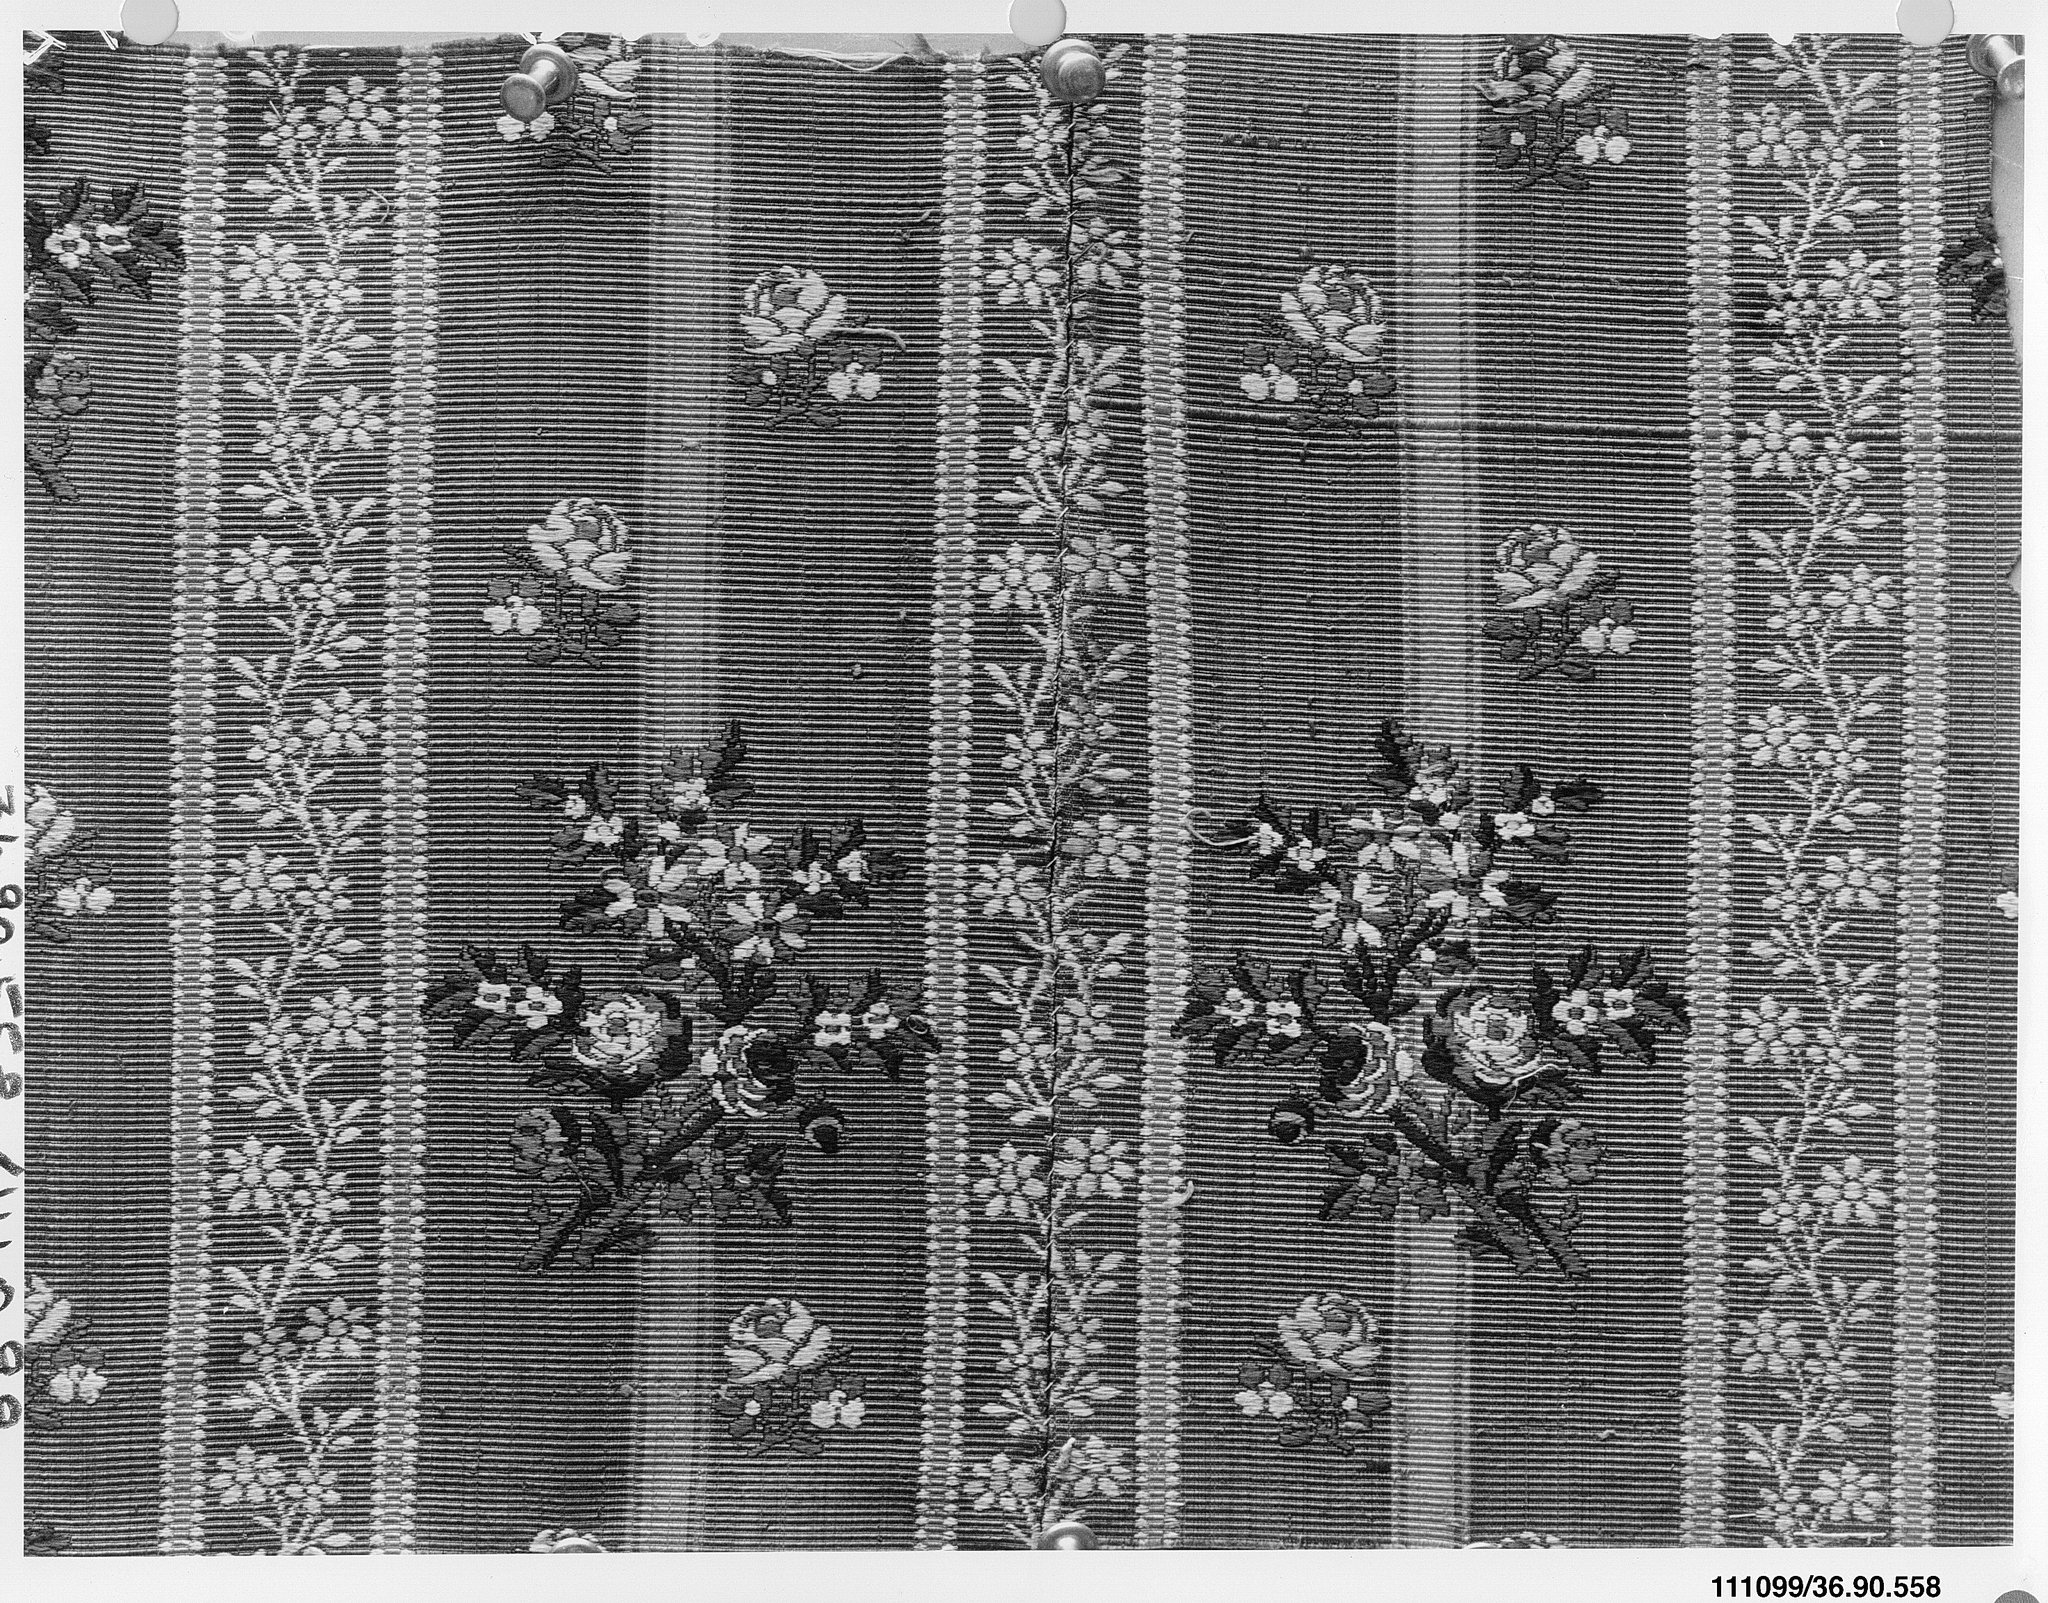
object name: piece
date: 1767-1800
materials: silk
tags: roses